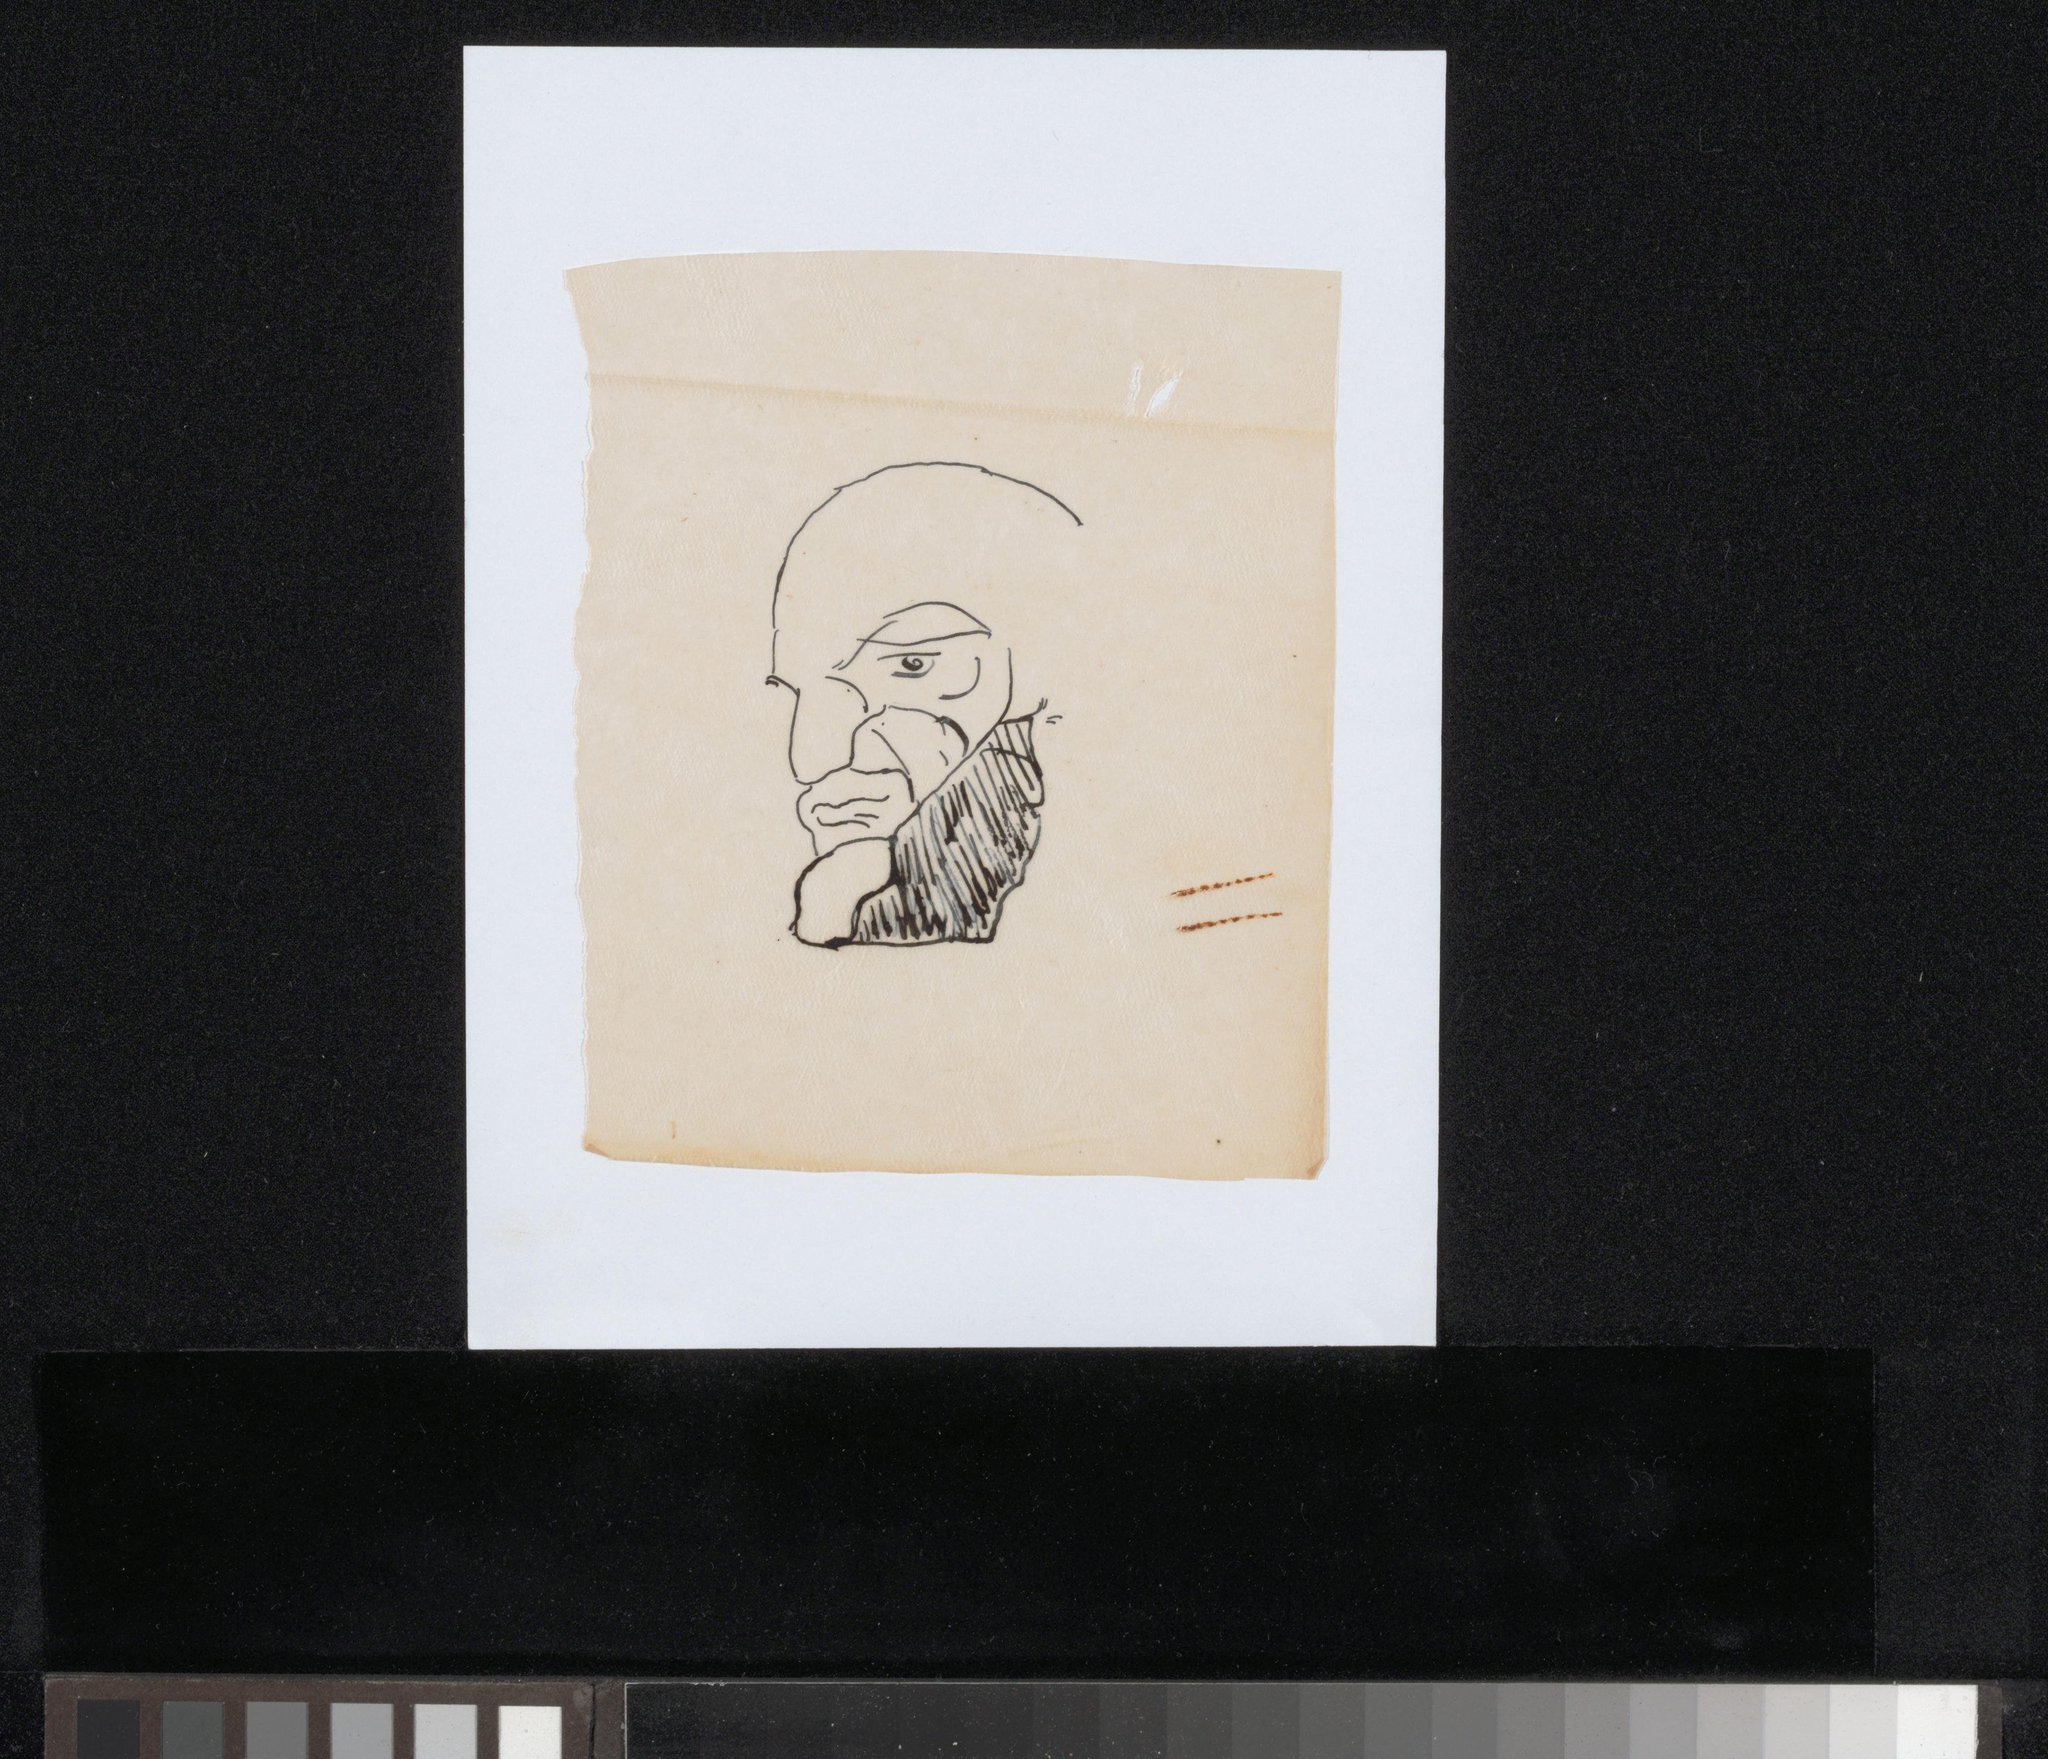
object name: letter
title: Brief aan Willem Bogtman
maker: richard nicolaüs roland holst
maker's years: 1868-1938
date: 1926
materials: ink, paper, pencil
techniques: pen, writing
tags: haarlem, willem bogtman, drawing, applied arts, arts and crafts; industrial design, the apostle and evangelist matthew (mattheus); possible attributes: angel, axe, book, halberd, pen and inkhorn, purse, scroll, square, sword - portrait of male saint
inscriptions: watermark